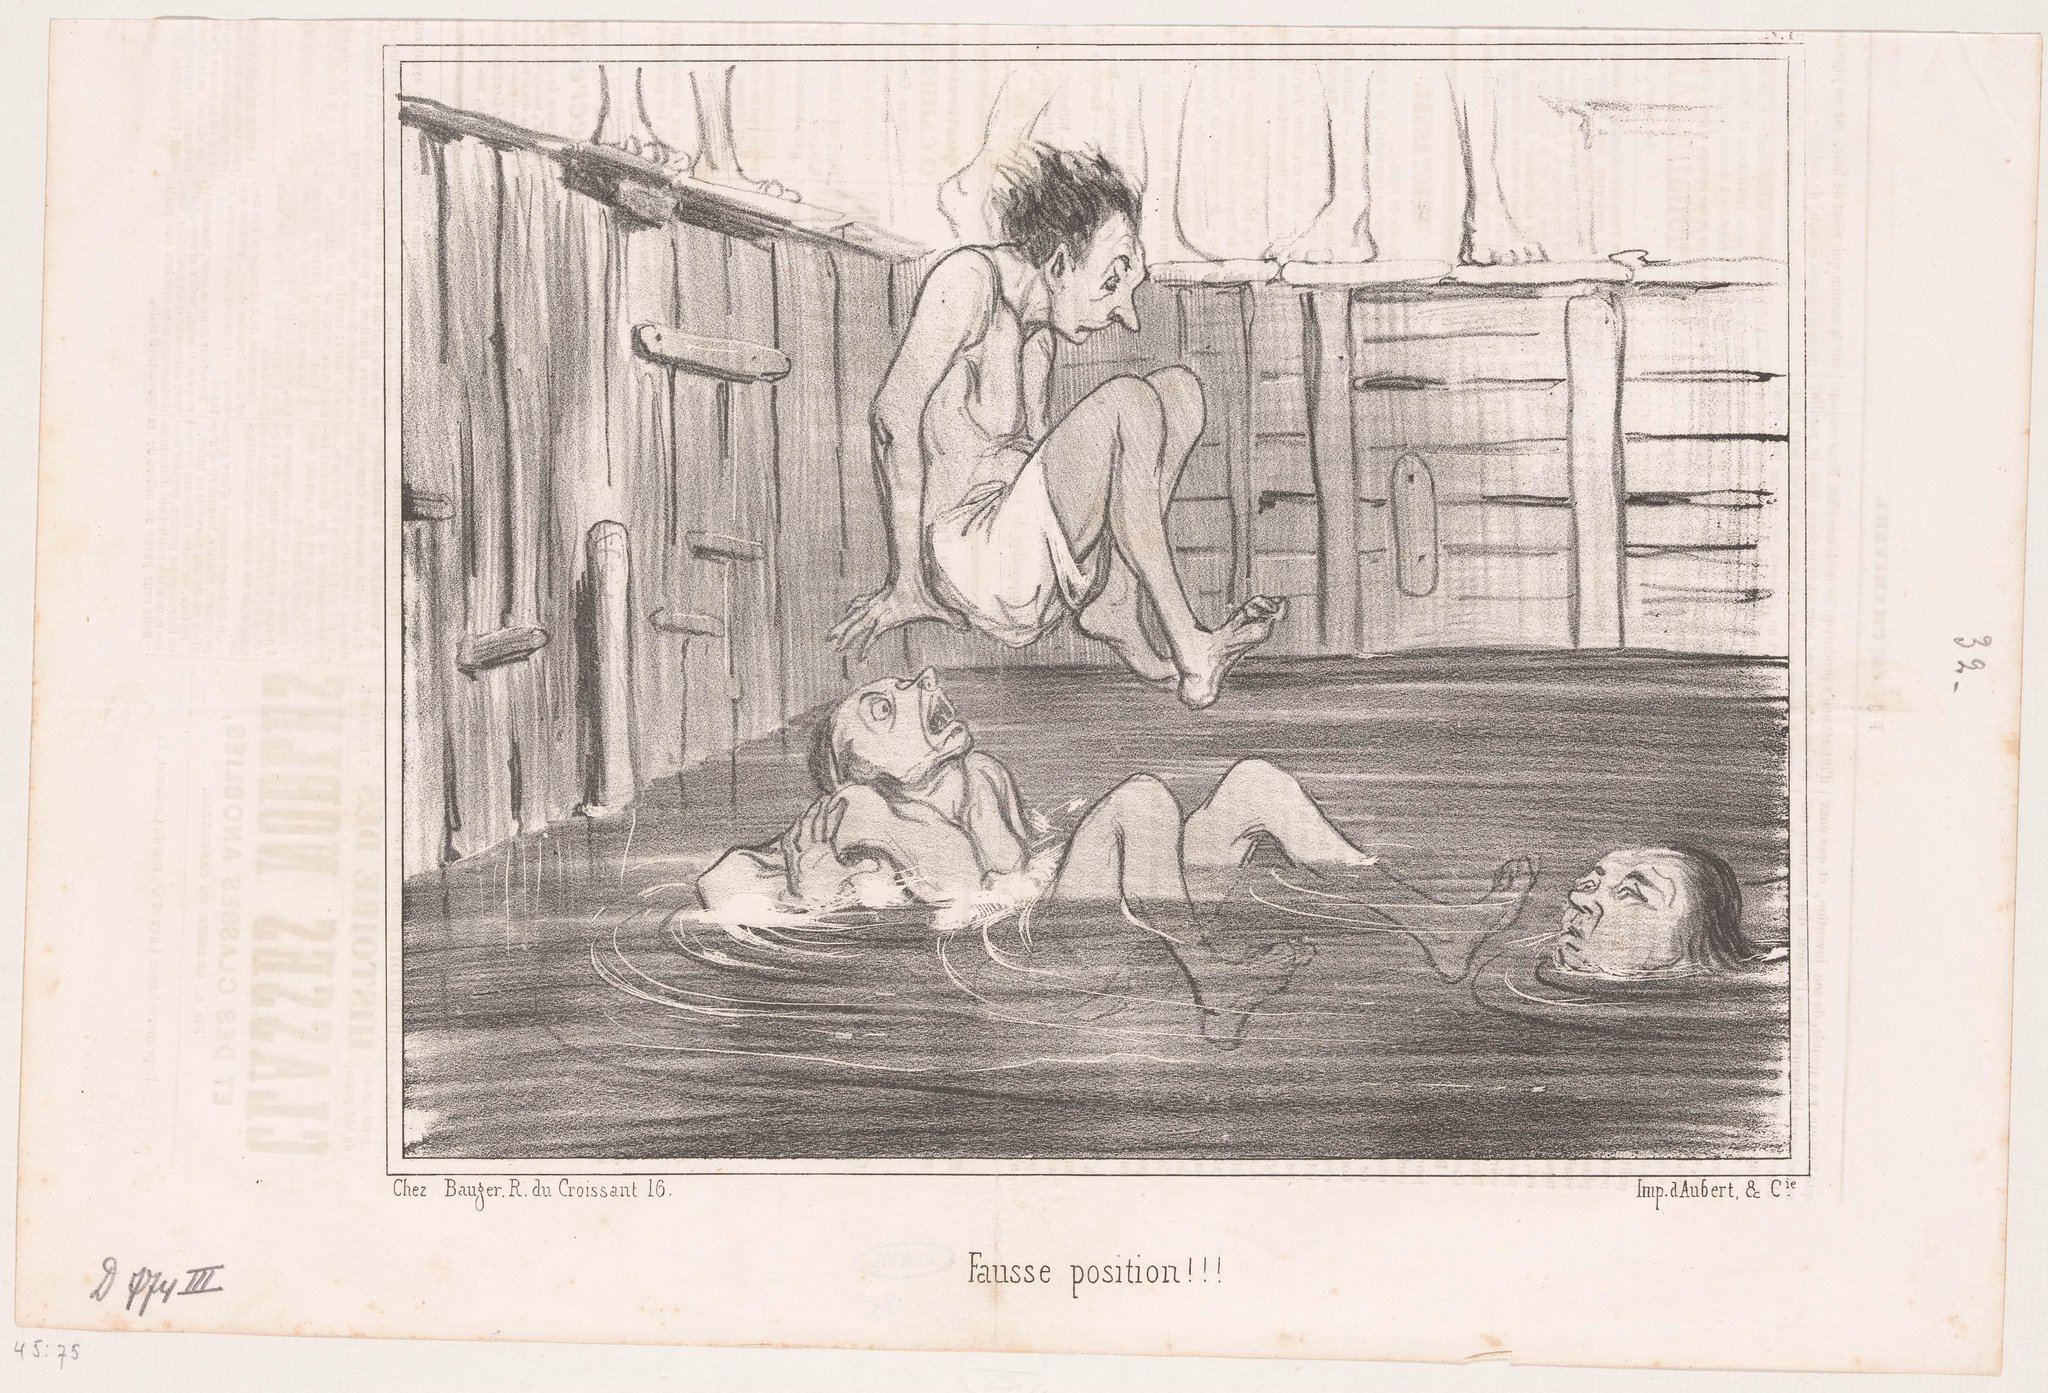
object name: cartoon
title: Man springt boven andere man het zwembad in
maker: honoré daumier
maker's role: draughtsman, painter, print maker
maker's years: 1808-1879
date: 1840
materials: paper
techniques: letterpress printing, lithograph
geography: paris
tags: caricatures (human types), public baths, swimming (movement in water)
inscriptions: collector's mark: Lugt 2228a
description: Prent mogelijk uit: Le Charivari, 22 juni 1840.